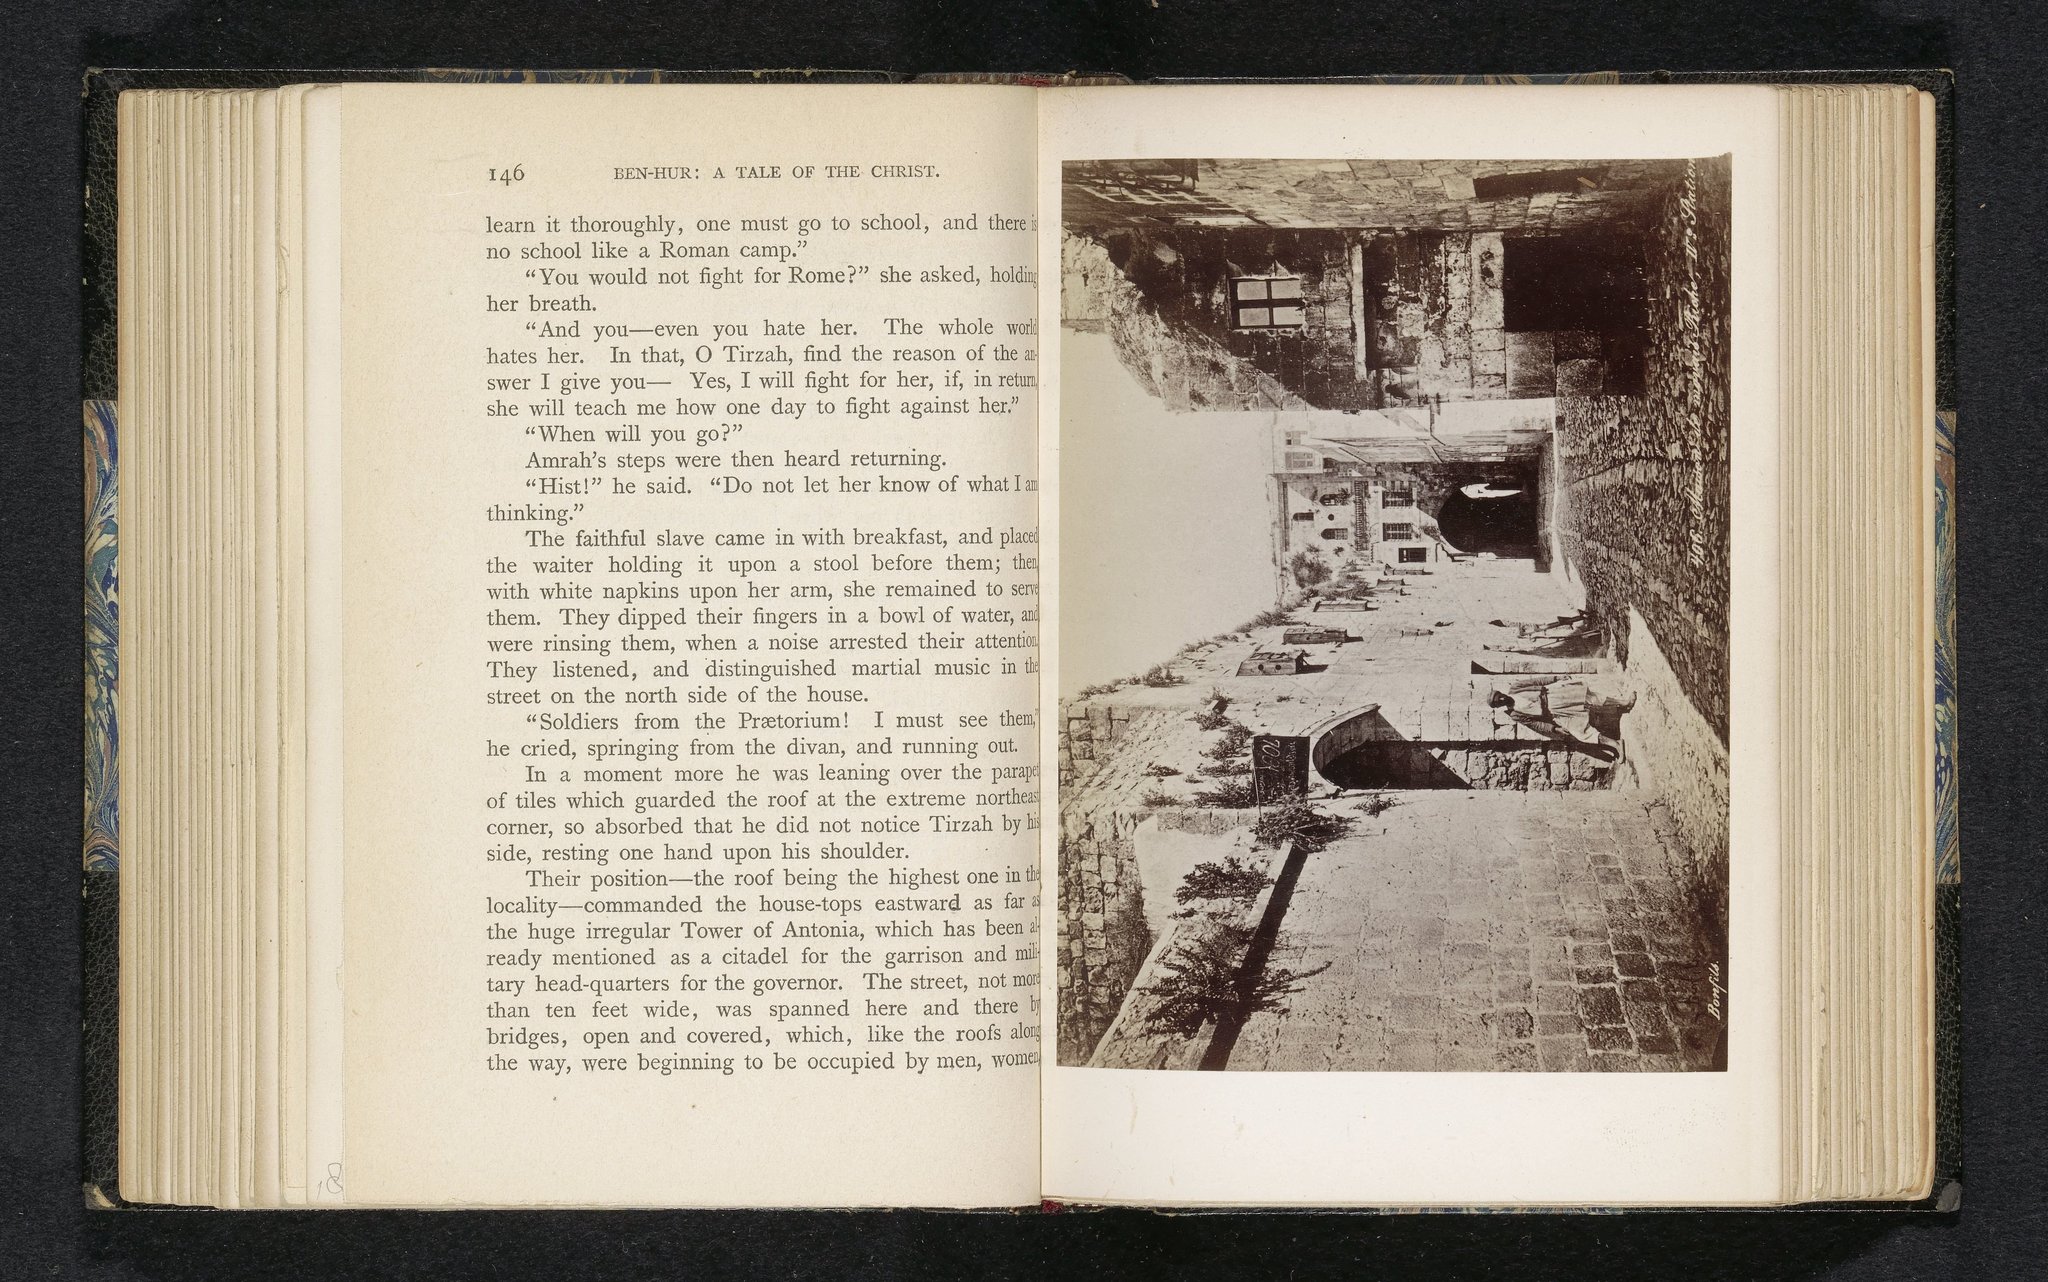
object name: page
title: Straat te Jeruzalem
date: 1883-1888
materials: photographic support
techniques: albumen print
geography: jerusalem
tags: street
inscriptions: number: ‘406’